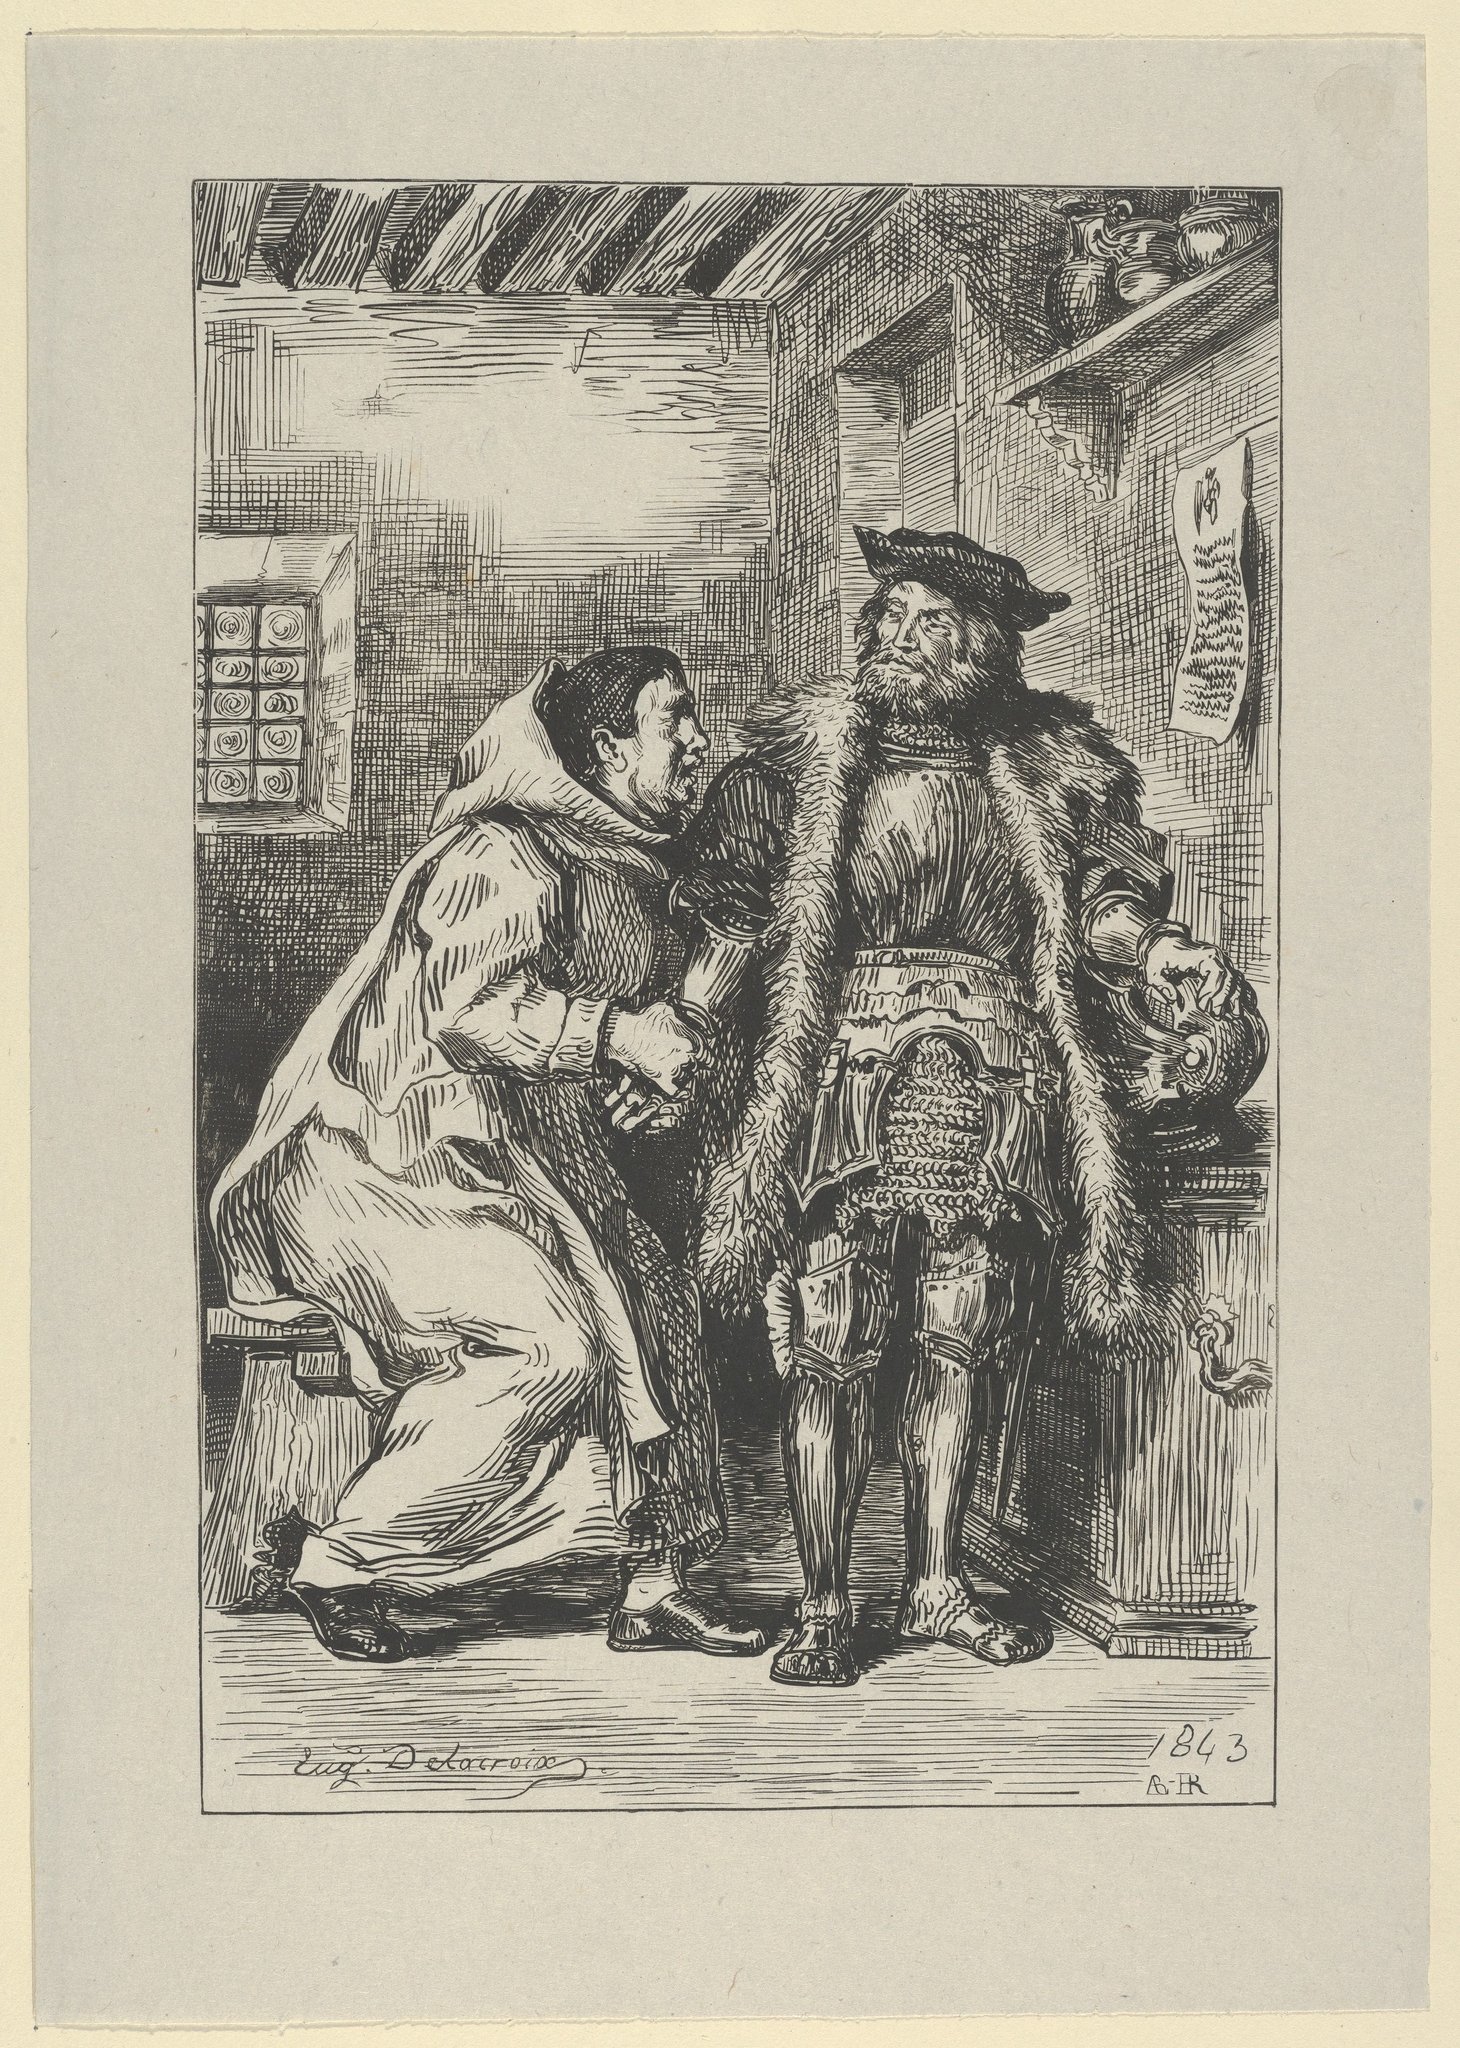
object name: print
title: Goetz and Friar Martin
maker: eugène delacroix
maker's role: artist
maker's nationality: french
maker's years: 1798-1863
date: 1845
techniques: engraving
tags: men,women